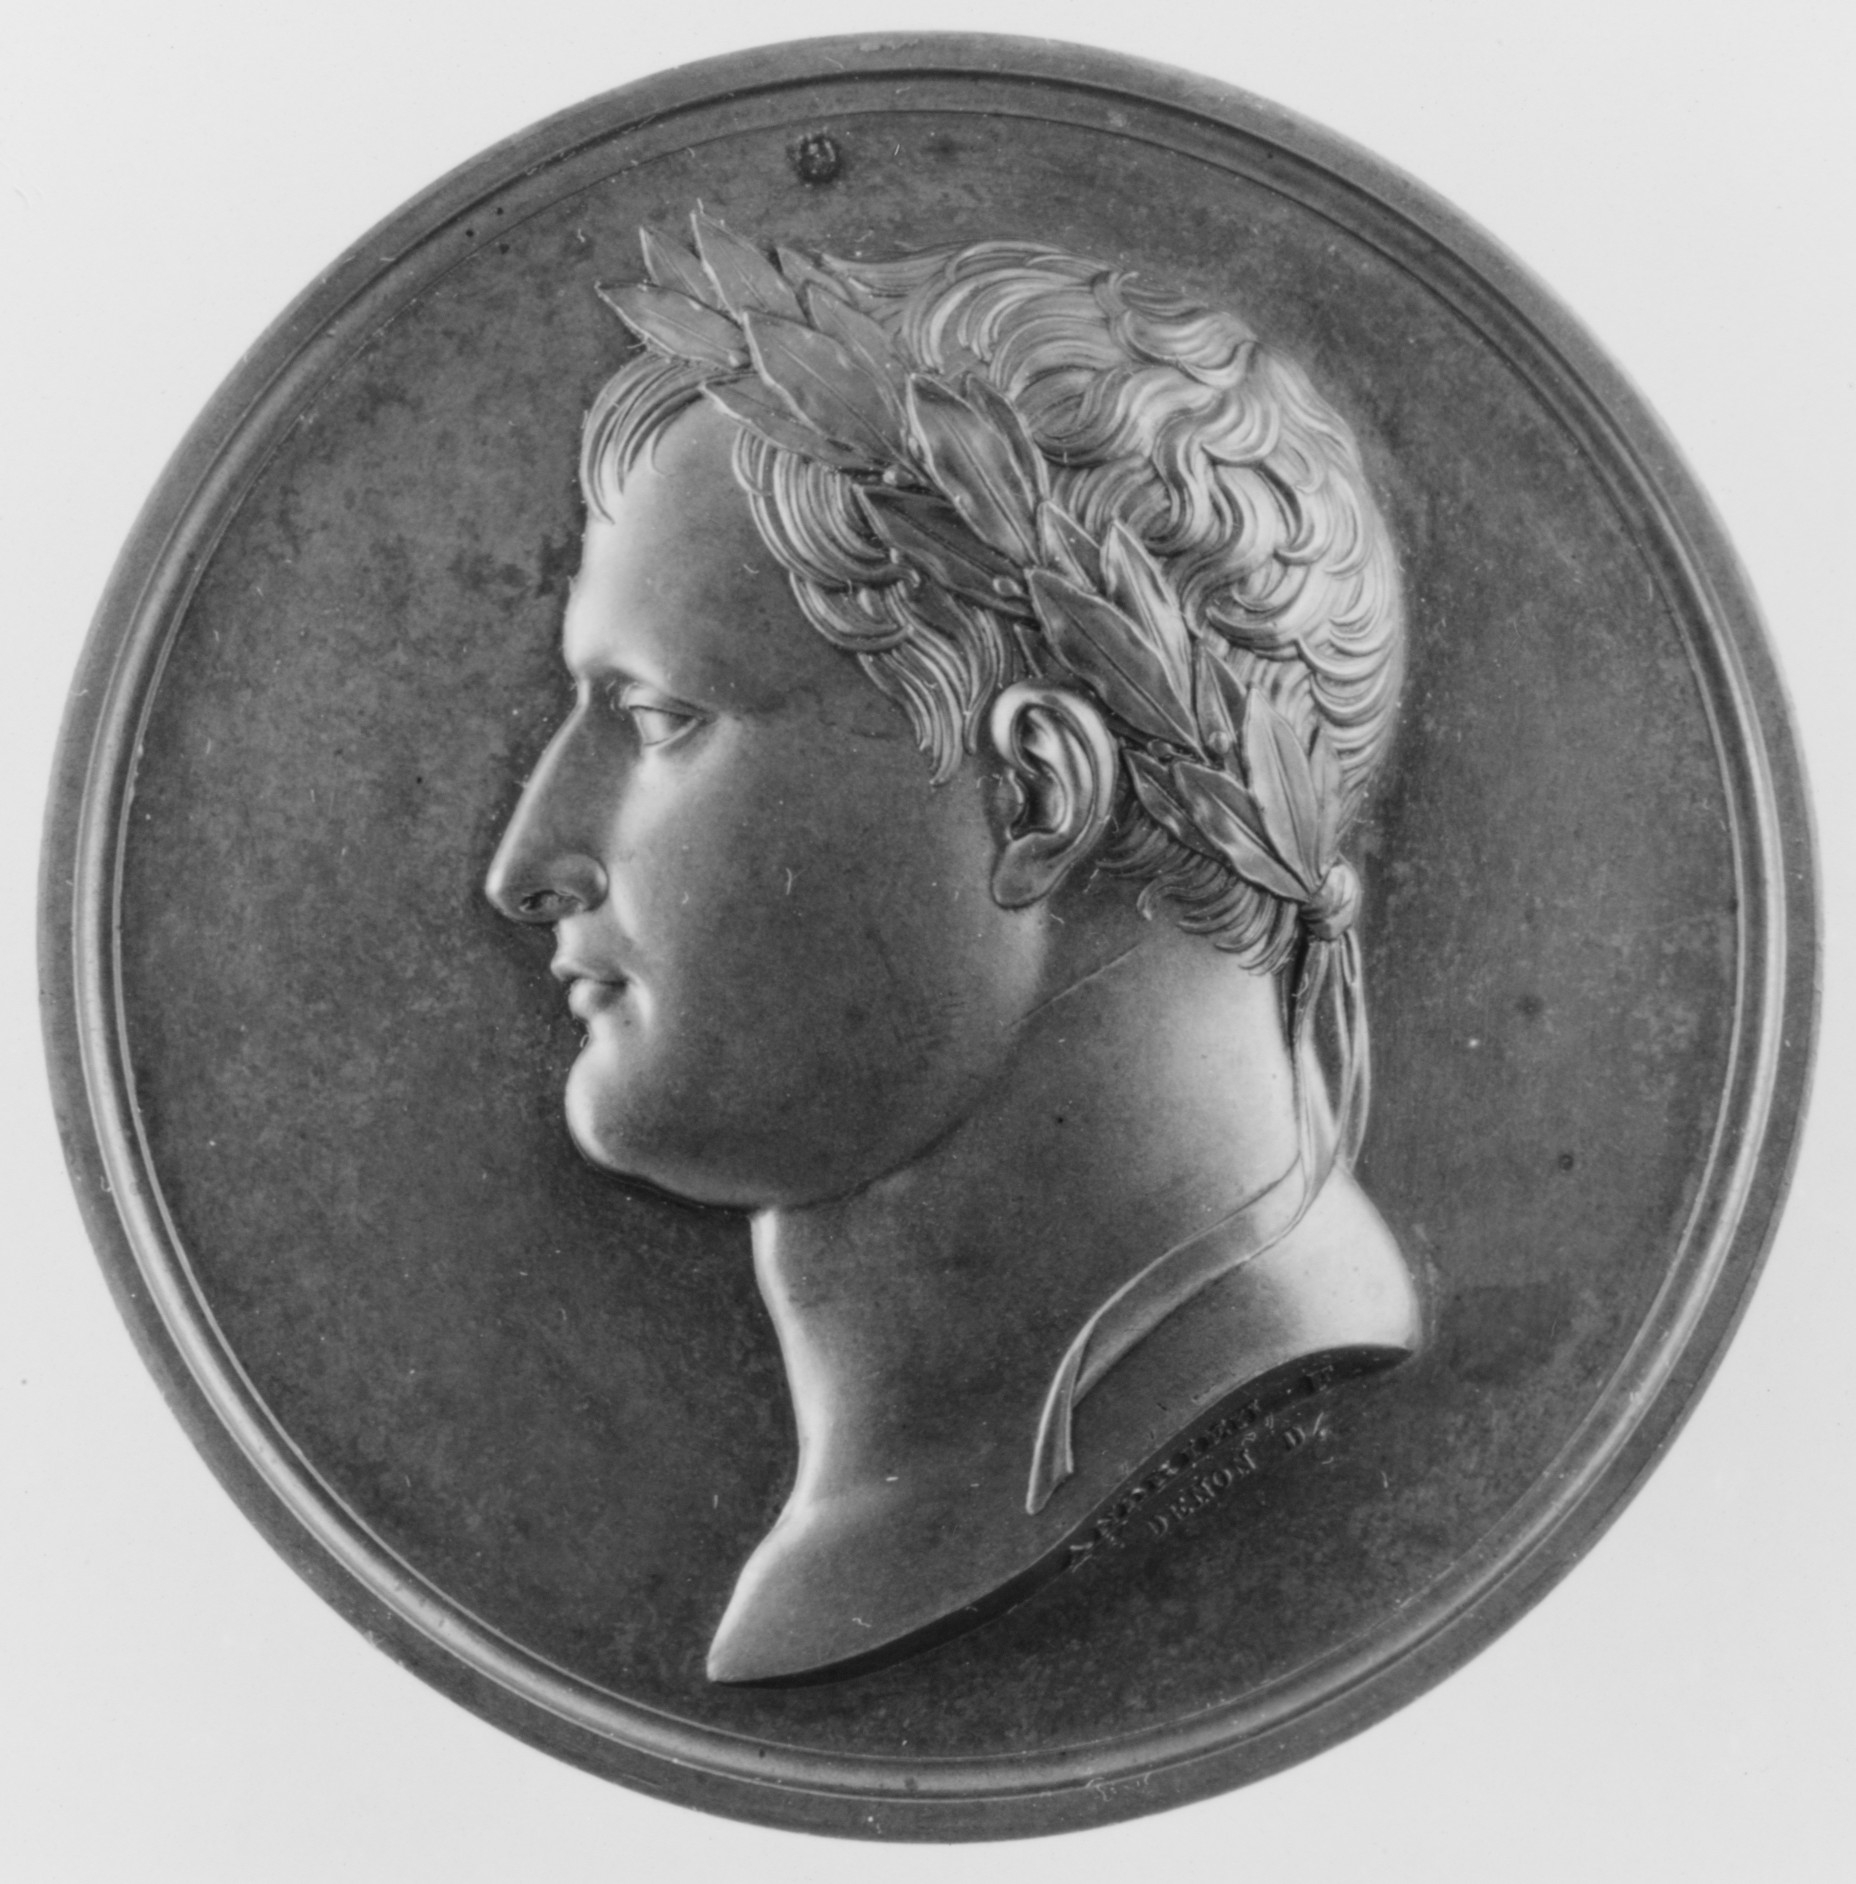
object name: medal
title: Napoleon, Baptism of the King of Rome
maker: bertrand andrieu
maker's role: artist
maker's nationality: french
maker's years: 1761-1822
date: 1811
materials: bronze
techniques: struck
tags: napoleon i,infants,men,profiles